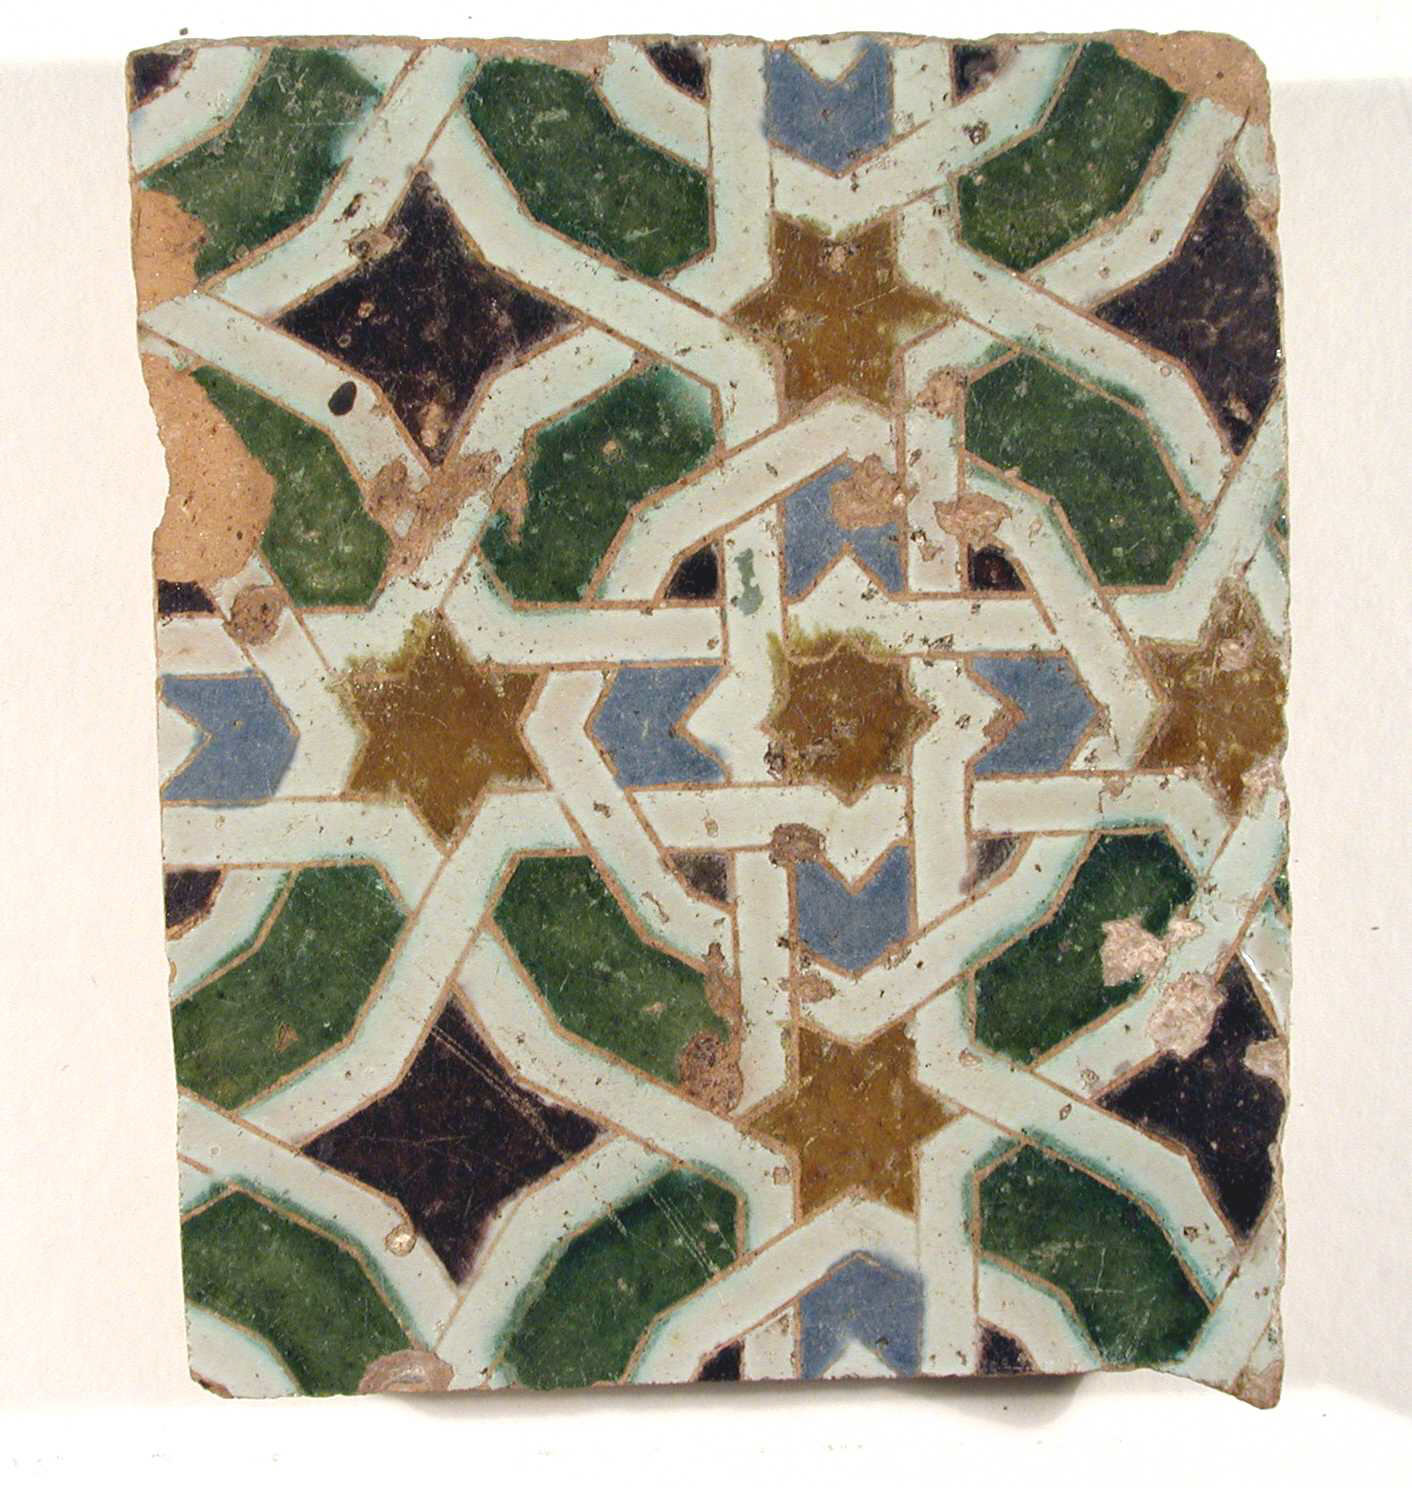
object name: tile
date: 1501-1700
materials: earthenware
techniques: glazing